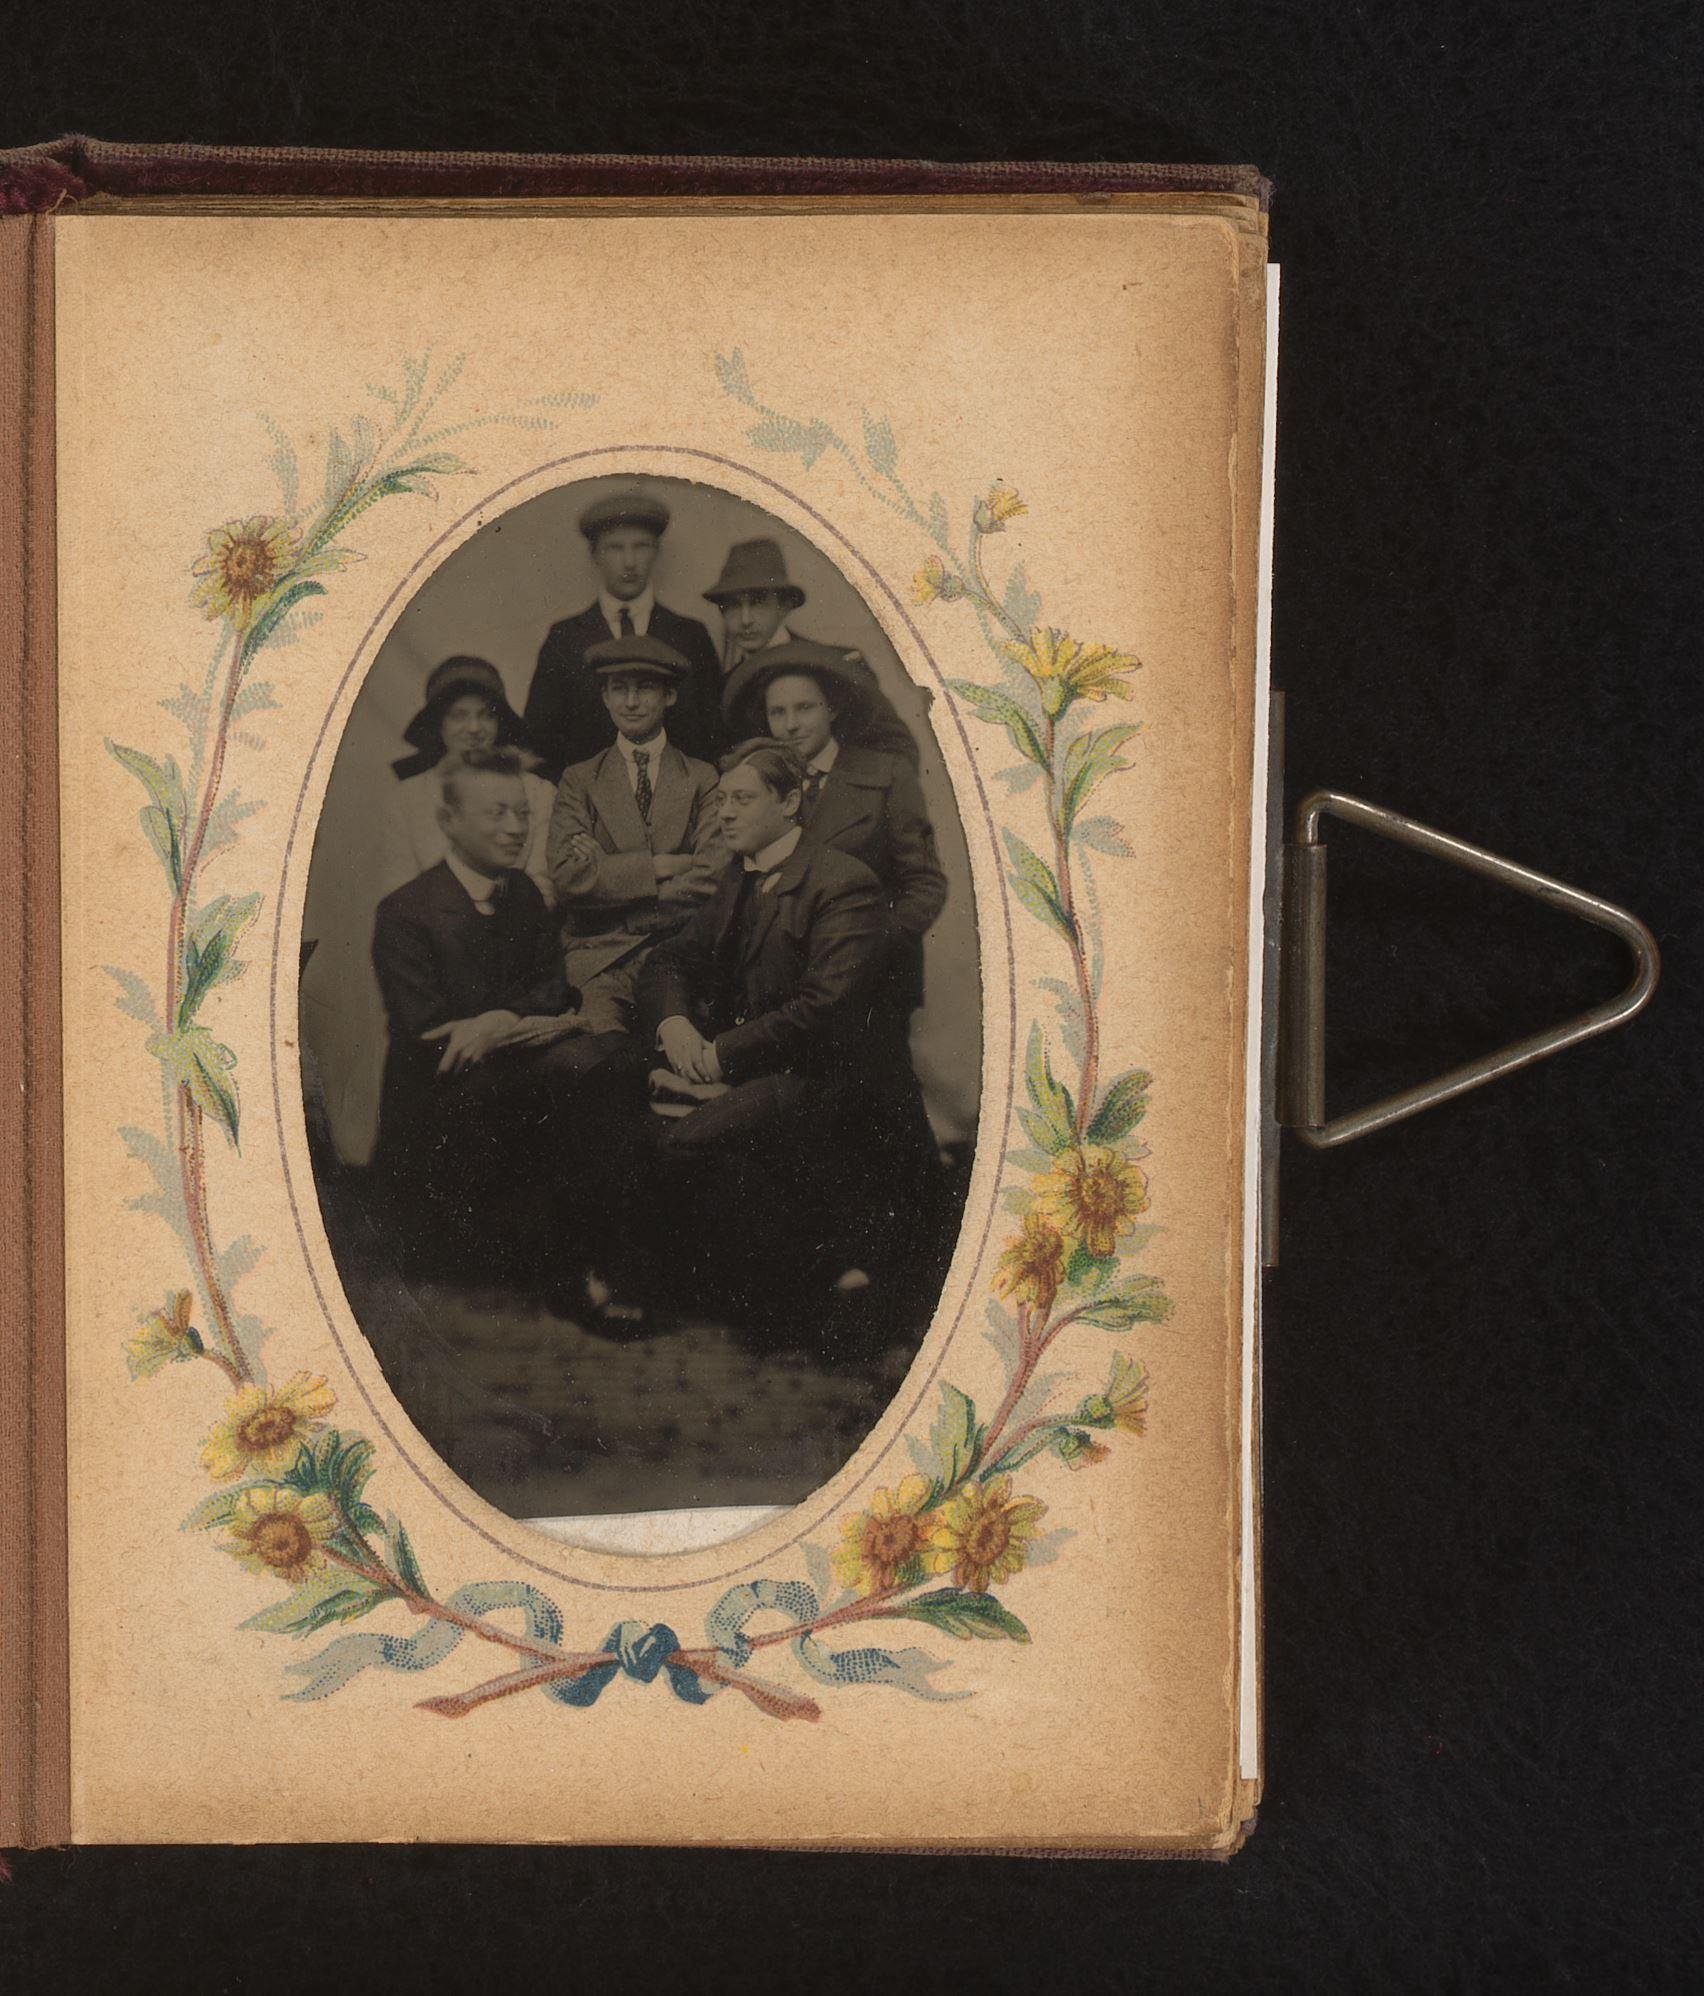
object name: photograph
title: Familieportret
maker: Anonymous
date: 1870-1882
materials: iron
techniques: ferrotyping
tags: adult woman, head-gear, adult man, historical persons, anonymous historical persons portrayed in a group, in a group-portrait